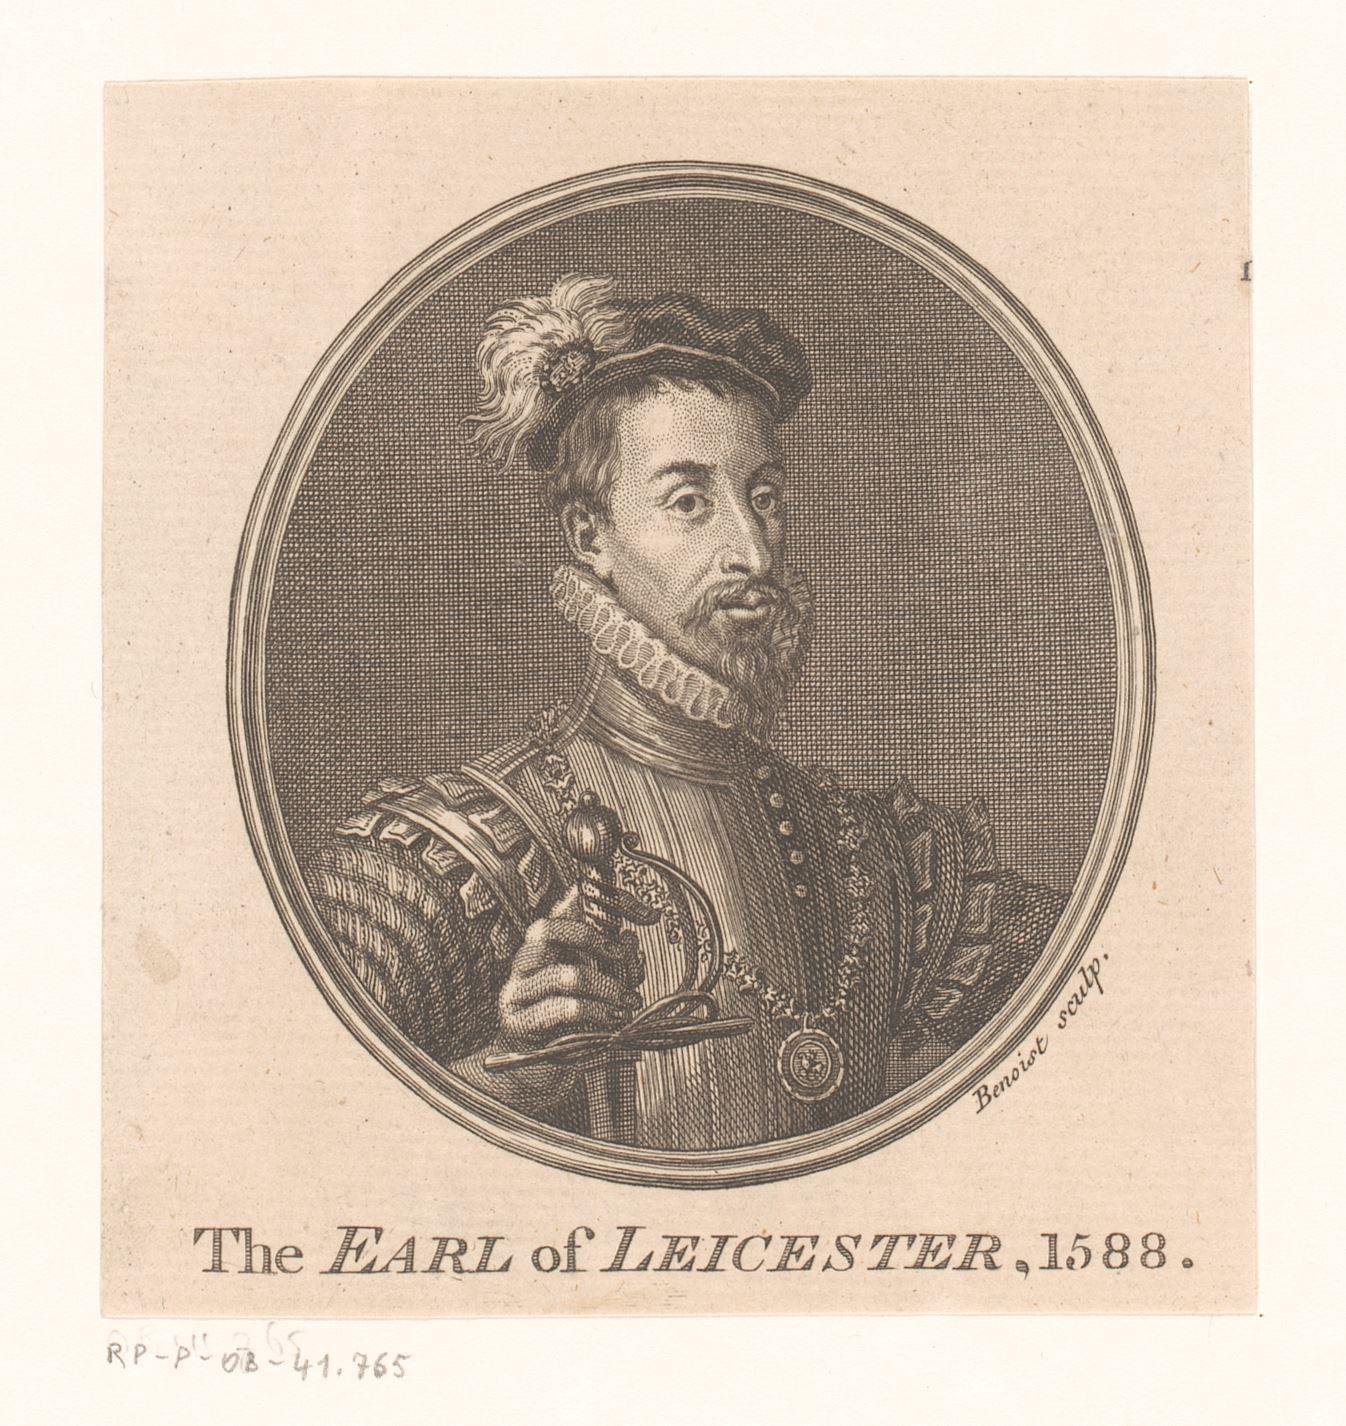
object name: print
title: Portret van Robert Dudley, graaf van Leicester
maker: guillaume philippe benoist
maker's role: print maker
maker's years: 1725-1800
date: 1735-1800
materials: paper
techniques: engraving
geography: france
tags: robert dudley (1st earl of leicester), ornament ~ medallion, historical persons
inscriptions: collector's mark: Lugt 2228